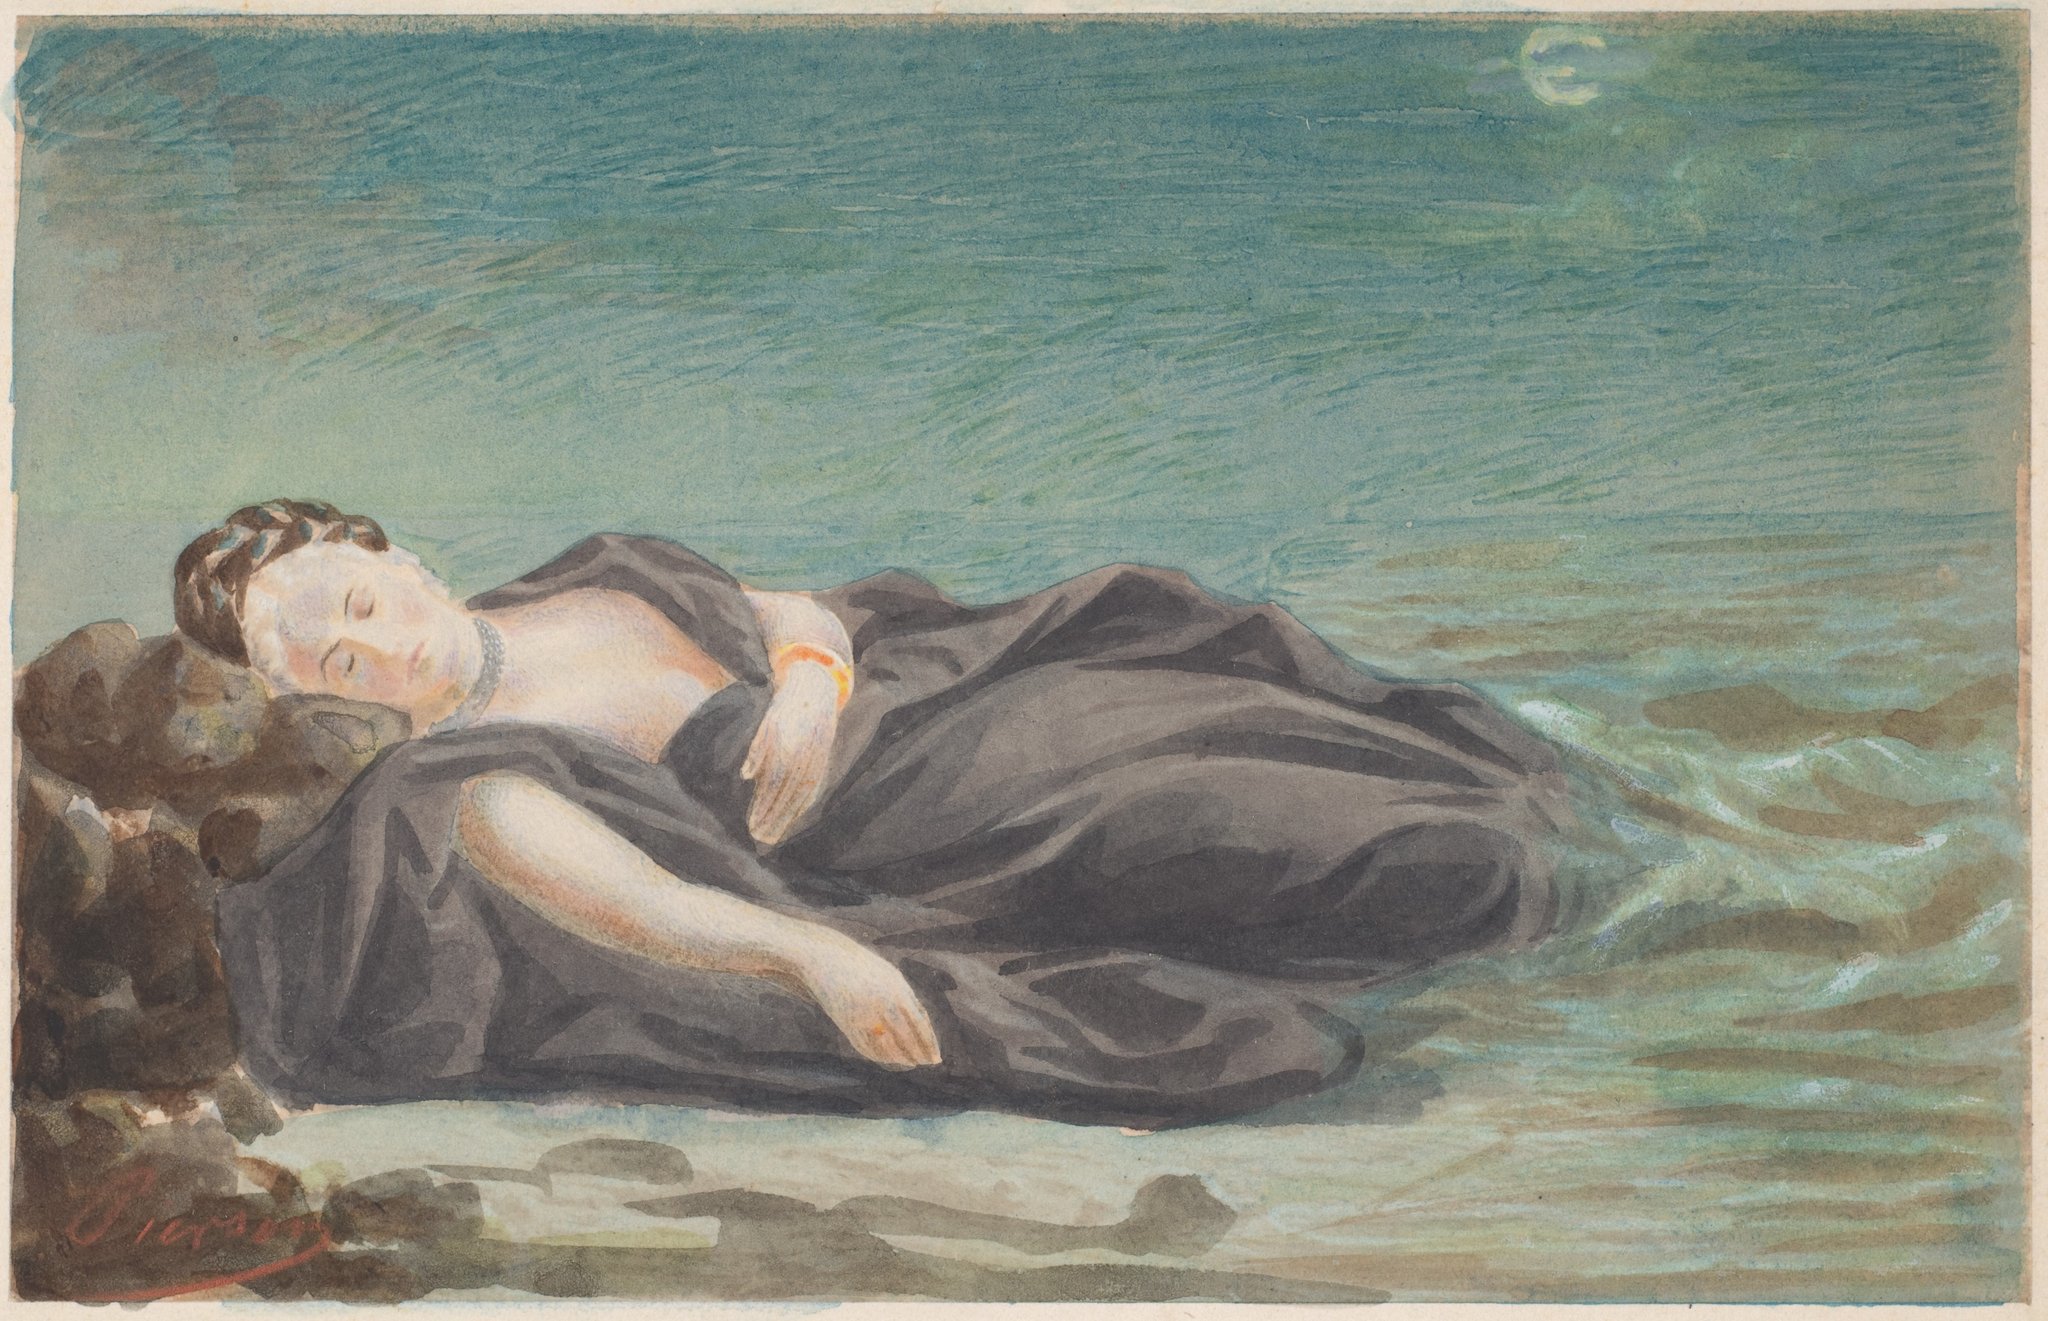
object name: photograph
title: Virginie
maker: pierre-louis pierson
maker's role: artist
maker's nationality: french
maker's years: 1822-1913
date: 1860-1869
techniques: glass negative, salted paper print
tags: sleeping,women